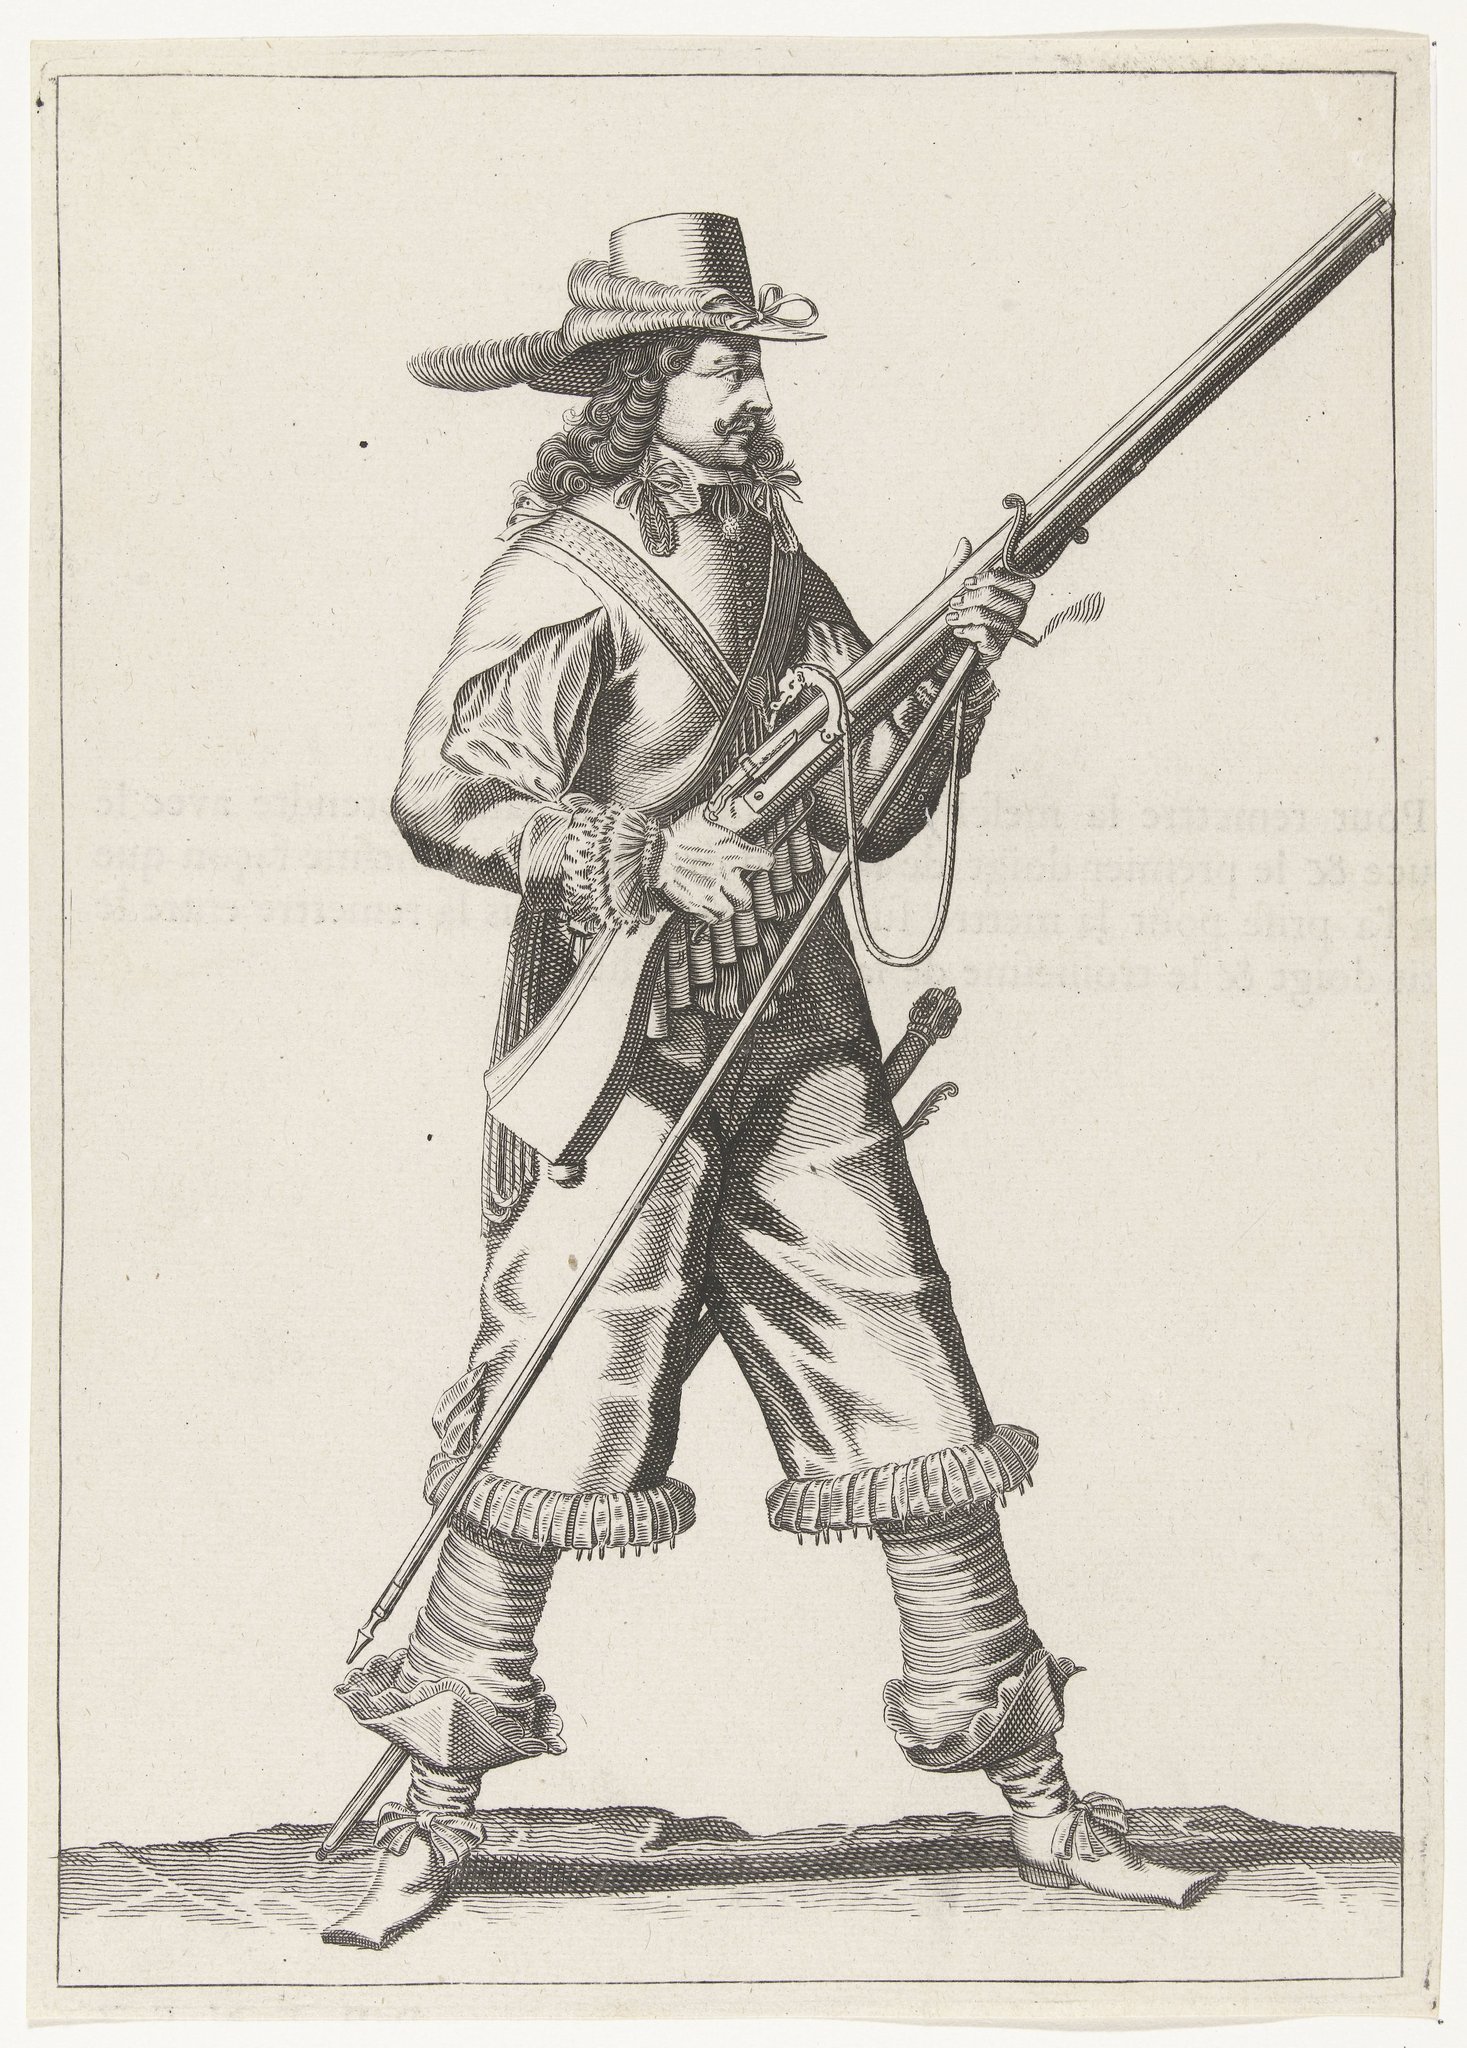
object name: print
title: Soldaat die zijn furket onder zijn musket plaatst, ca. 1645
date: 1645-1647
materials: paper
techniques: engraving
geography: southern netherlands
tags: handling of weapons ~ military training, weapons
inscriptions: annotation: ‘Ouvrez le bassinet p. 27’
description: Een soldaat, ten voeten uit, naar rechts, die een musket (een bepaald type vuurwapen) met de rechterhand schuin omhoog gericht vasthoudt, terwijl hij een furket (musketvork) onder de loop plaatst, ca. 1645. Bedrukt op achterzijde met tekst in het Frans. Vrij naar plaat 11 in de instructies voor het hanteren van het musket in de Wapenhandelinghe van J. de Gheyn. Krijgswezen rond 1600.